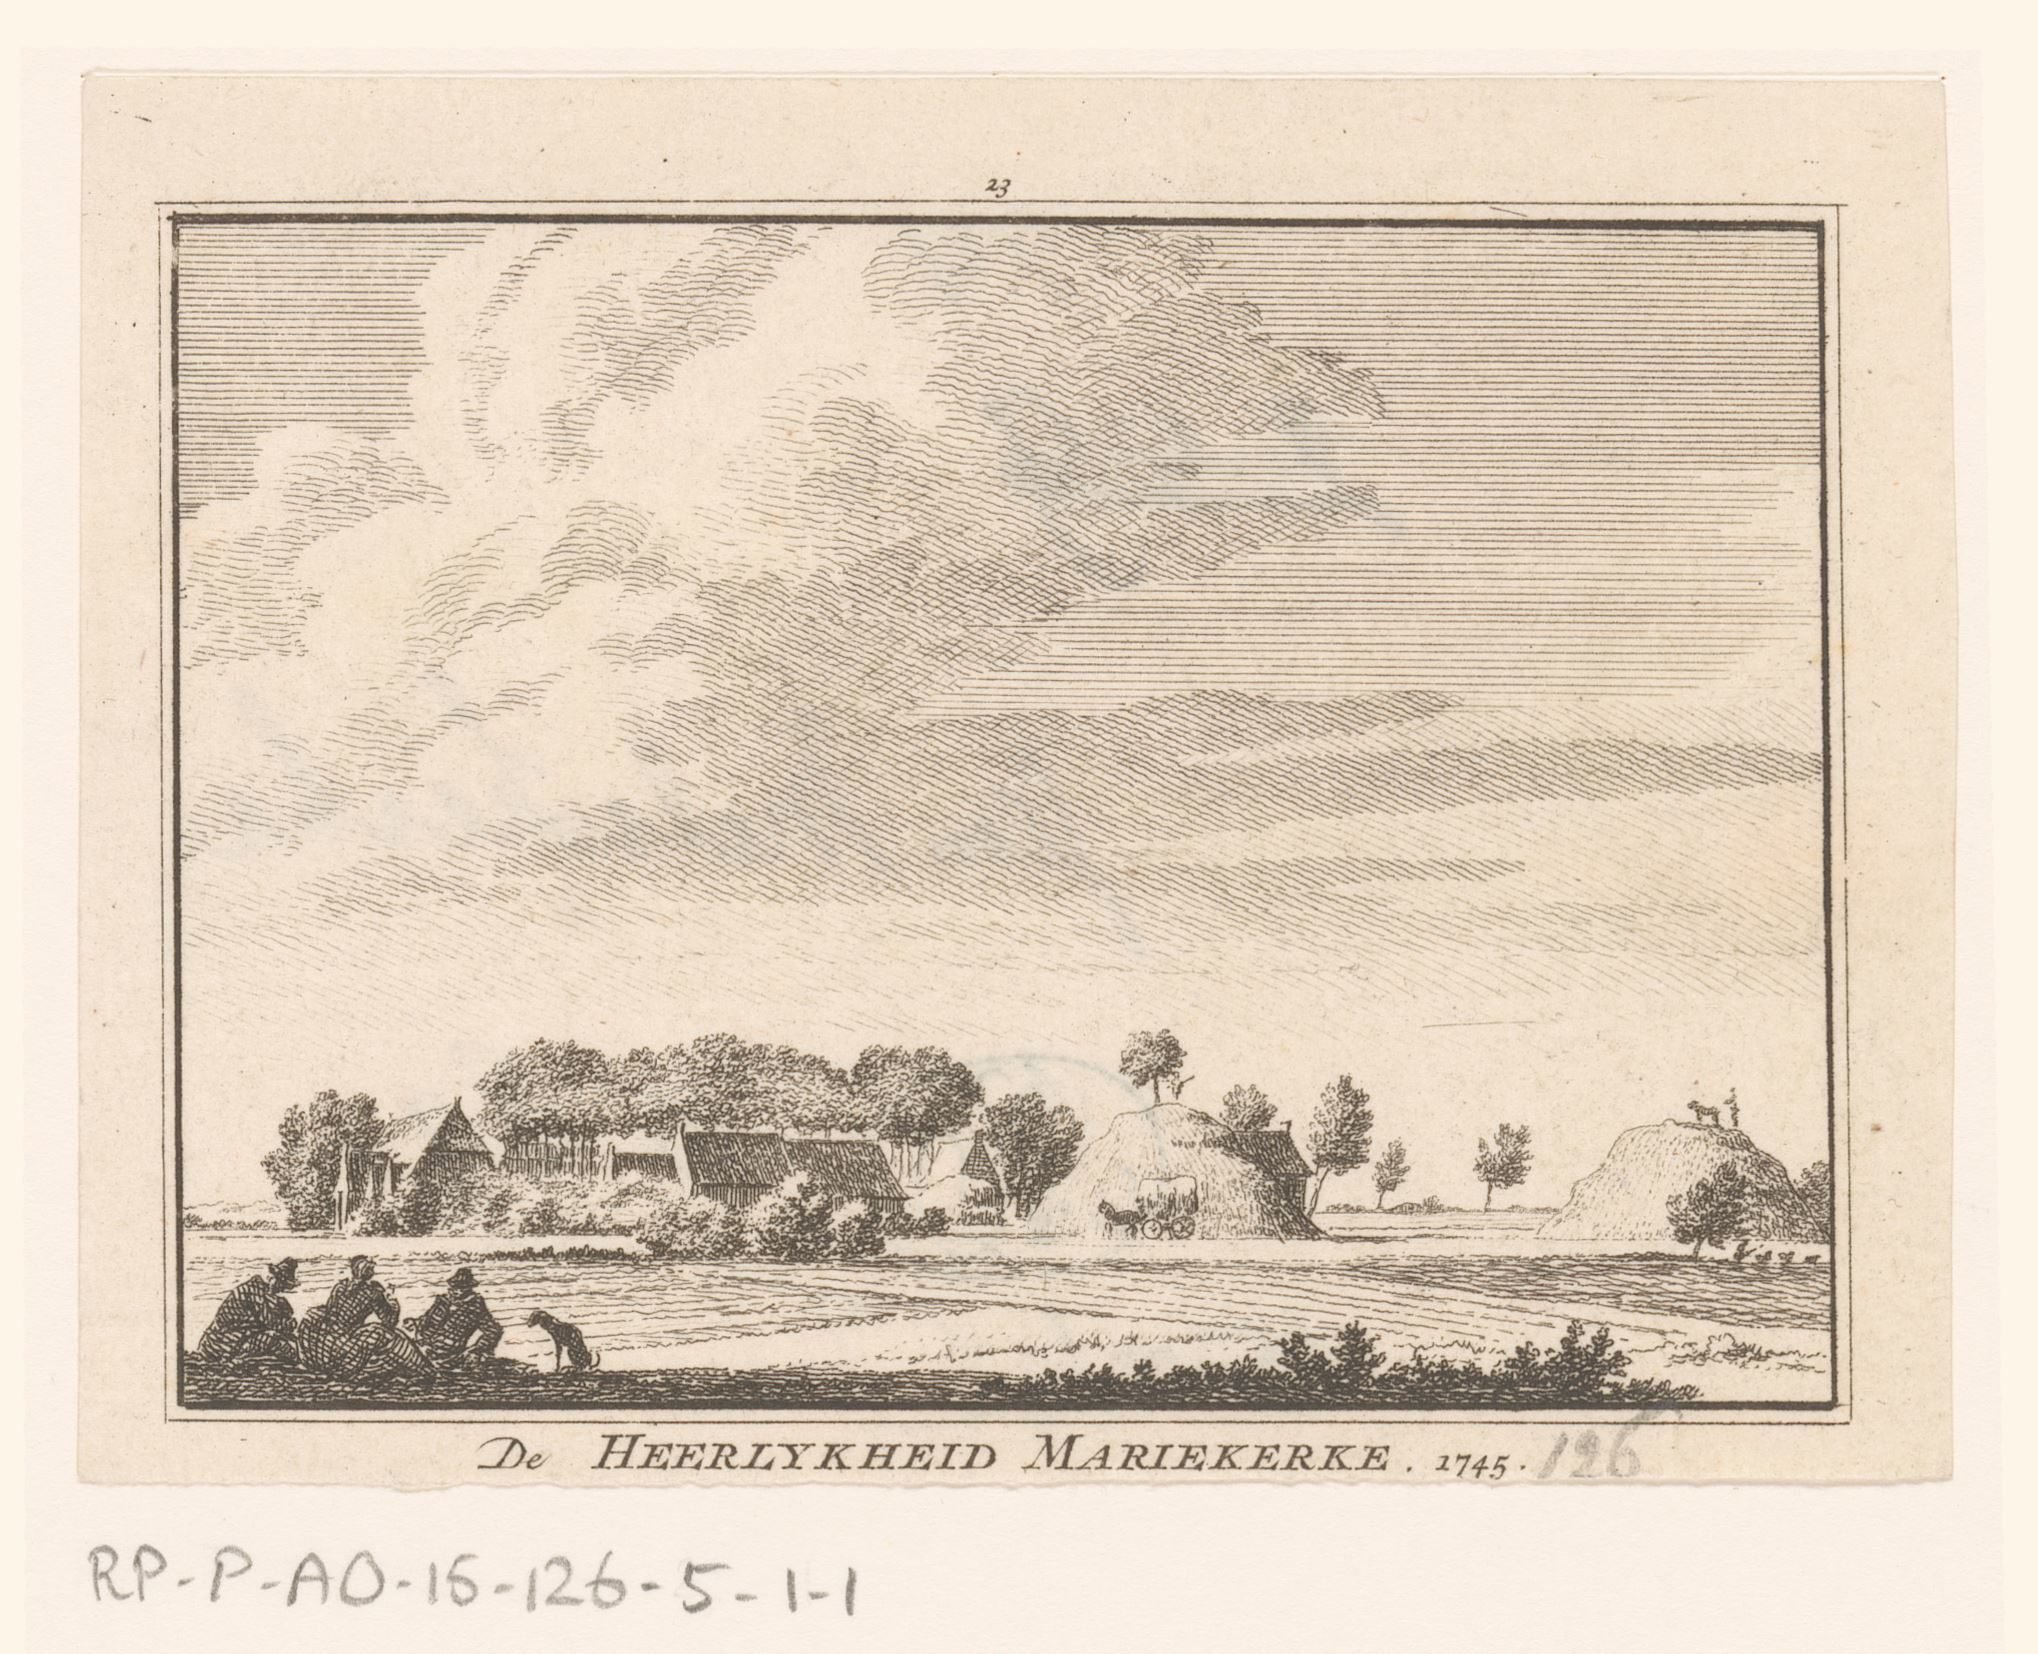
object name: print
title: Gezicht op de heerlijkheid Mariekerke, 1745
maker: hendrik spilman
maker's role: draughtsman, painter, print maker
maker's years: 1721-1784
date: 1754-1792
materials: paper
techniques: etching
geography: haarlem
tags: prospect of village, silhouette of village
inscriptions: collector's mark: Lugt 195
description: Prent ook gebruikt in: Het verheerlykt Nederland of kabinet van hedendaagsche gezigten van steden, dorpen (…). 9 delen. Amsterdam: Isaak Tirion en weduwe Isaak Tirion, 1745-1774, dl. 5 (1754), ill. 23. Of in: Nederlandsche tafereelen; of eene keurige verzameling van negen honderd fraaije gezigten van steden, dorpen, sloten, oudheden [….]. 9 delen. Amsterdam: Jan de Groot, 1792, dl. 5, ill. 23.